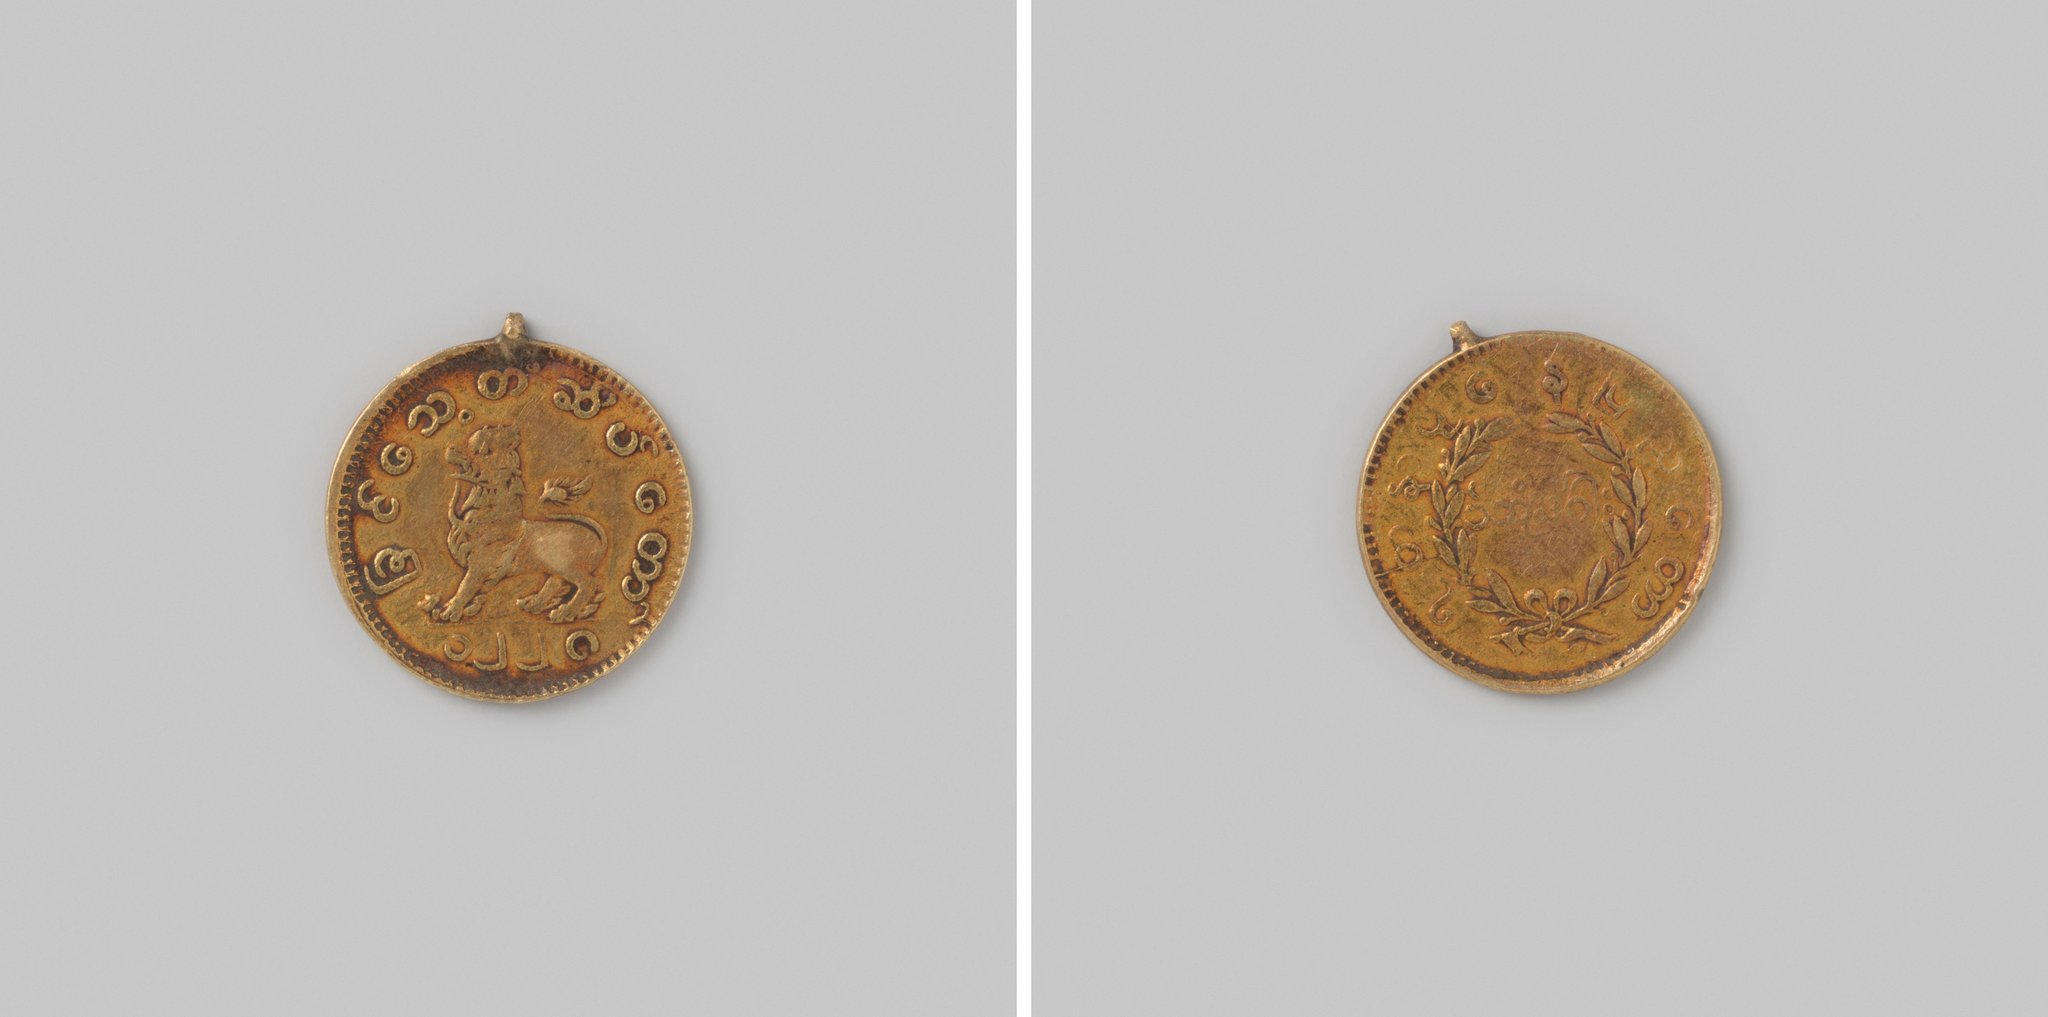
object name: coin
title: Birma, Mindon Min, 1/8 mohur of pe, 1228 [=1866]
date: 1866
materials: gold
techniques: striking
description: Gouden munt. Voorzijde: een Birmese leeuw. Daaronder jaartal: 1228. Keerzijde: tussen twee samengebonden takken waarde-aanduiding in een regel. Gladde rand. NB: resten van montage-oog.